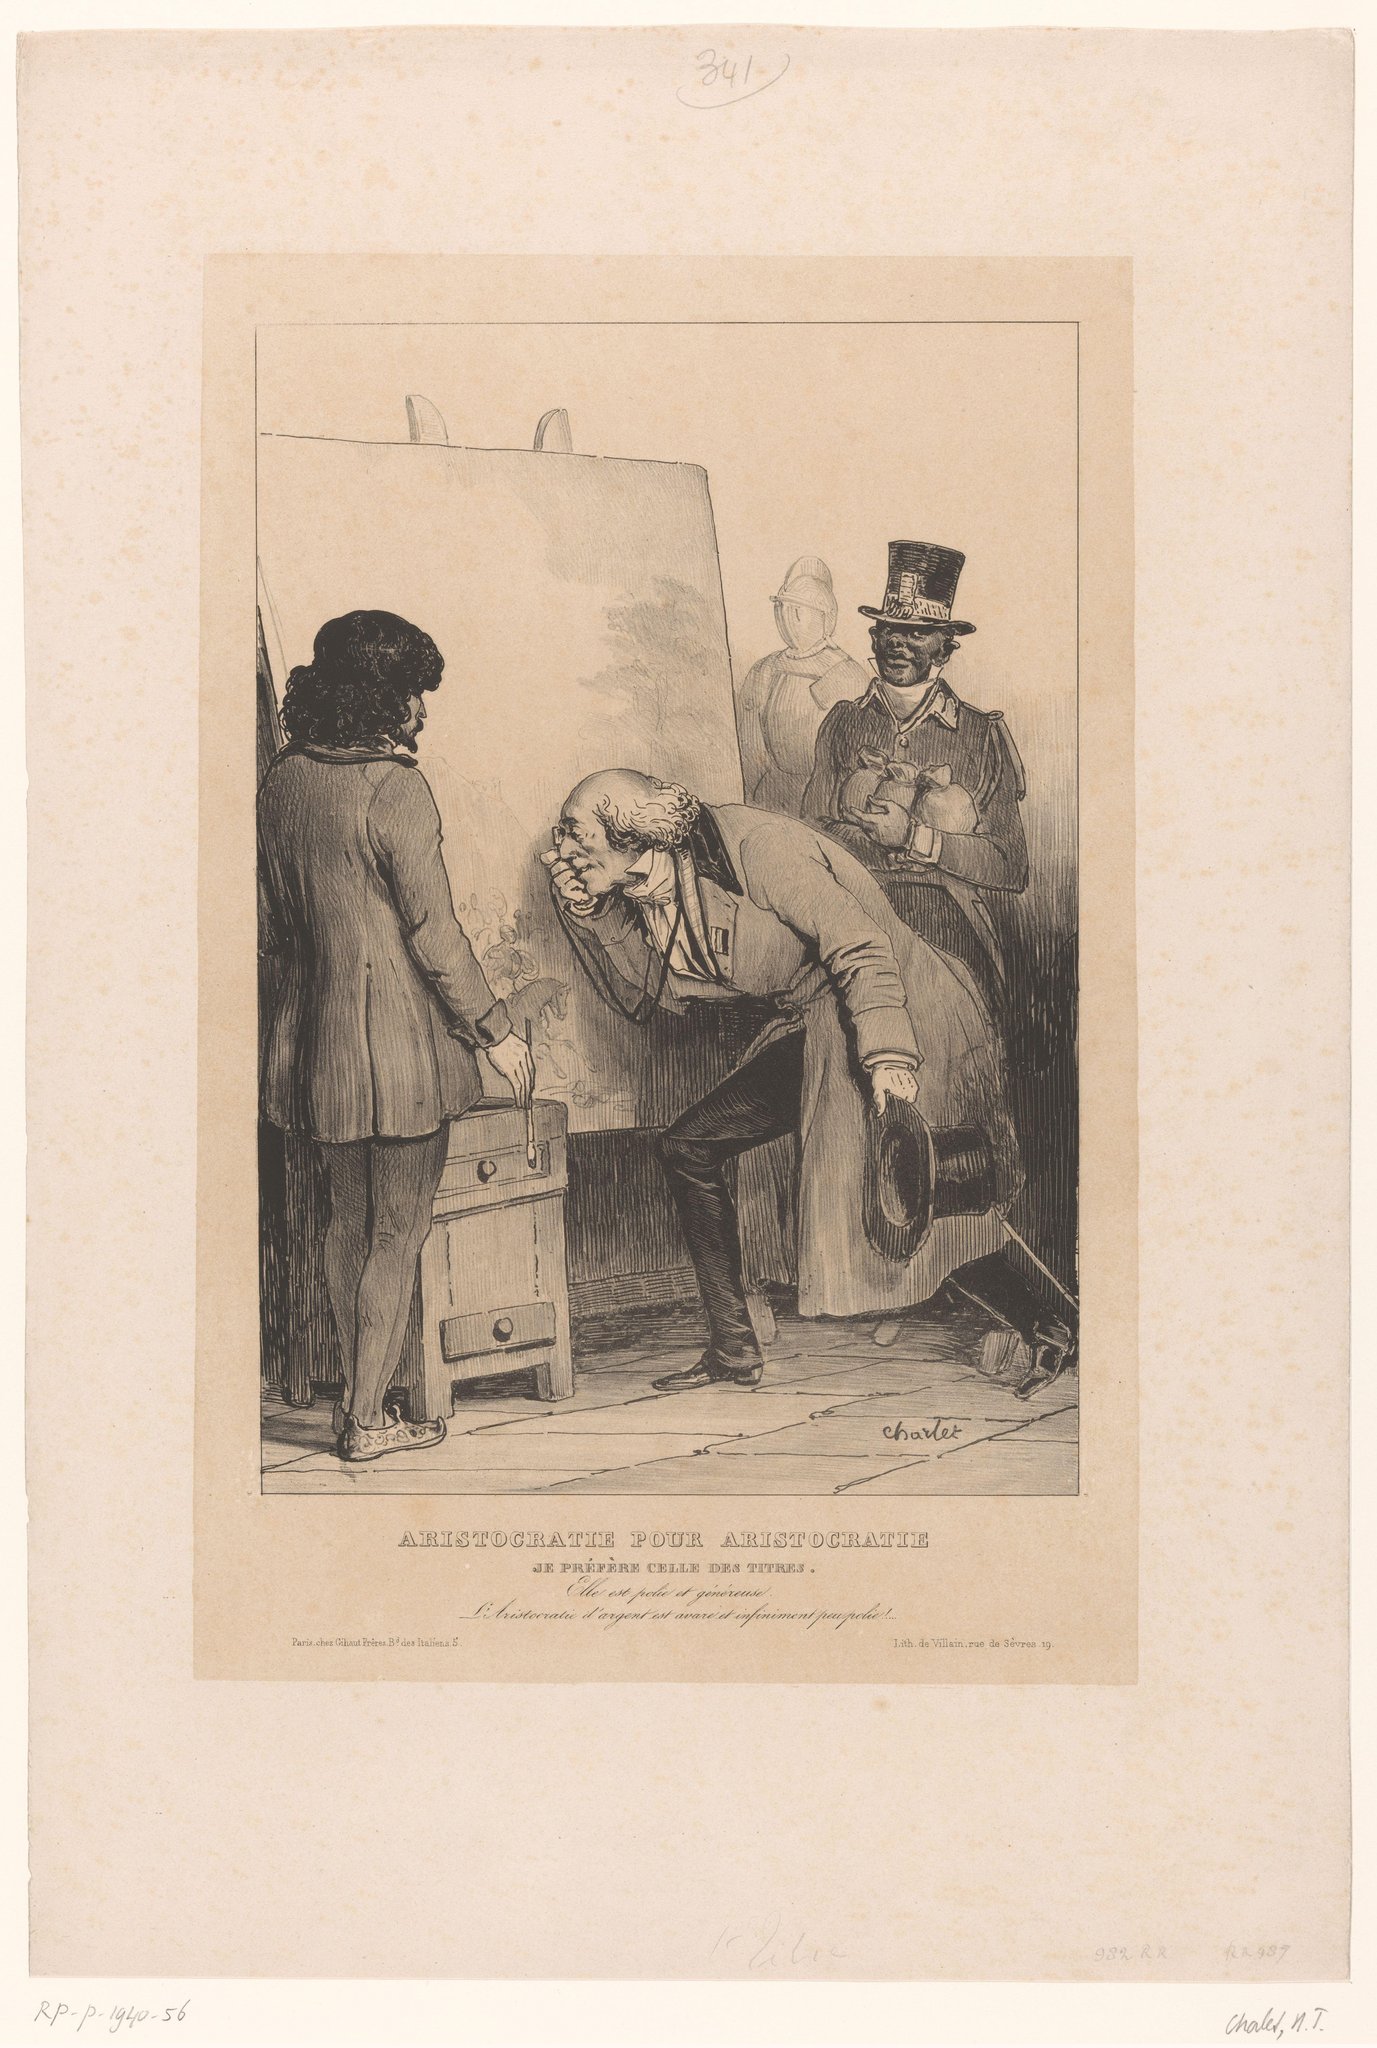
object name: print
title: Schetsen in mezzotint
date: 1840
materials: paper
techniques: tone lithography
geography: paris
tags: aristocracy; 'aristocratia' (ripa), picture, painting, artist at work, in his workshop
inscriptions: collector's mark: Lugt 2166, collector's mark: Lugt 2760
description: De oude aristocraat verkiest de oude aristocratie met de titels boven de nieuwe aristocratie met het geld. De oude aristocratie vindt hij meer beleefd.